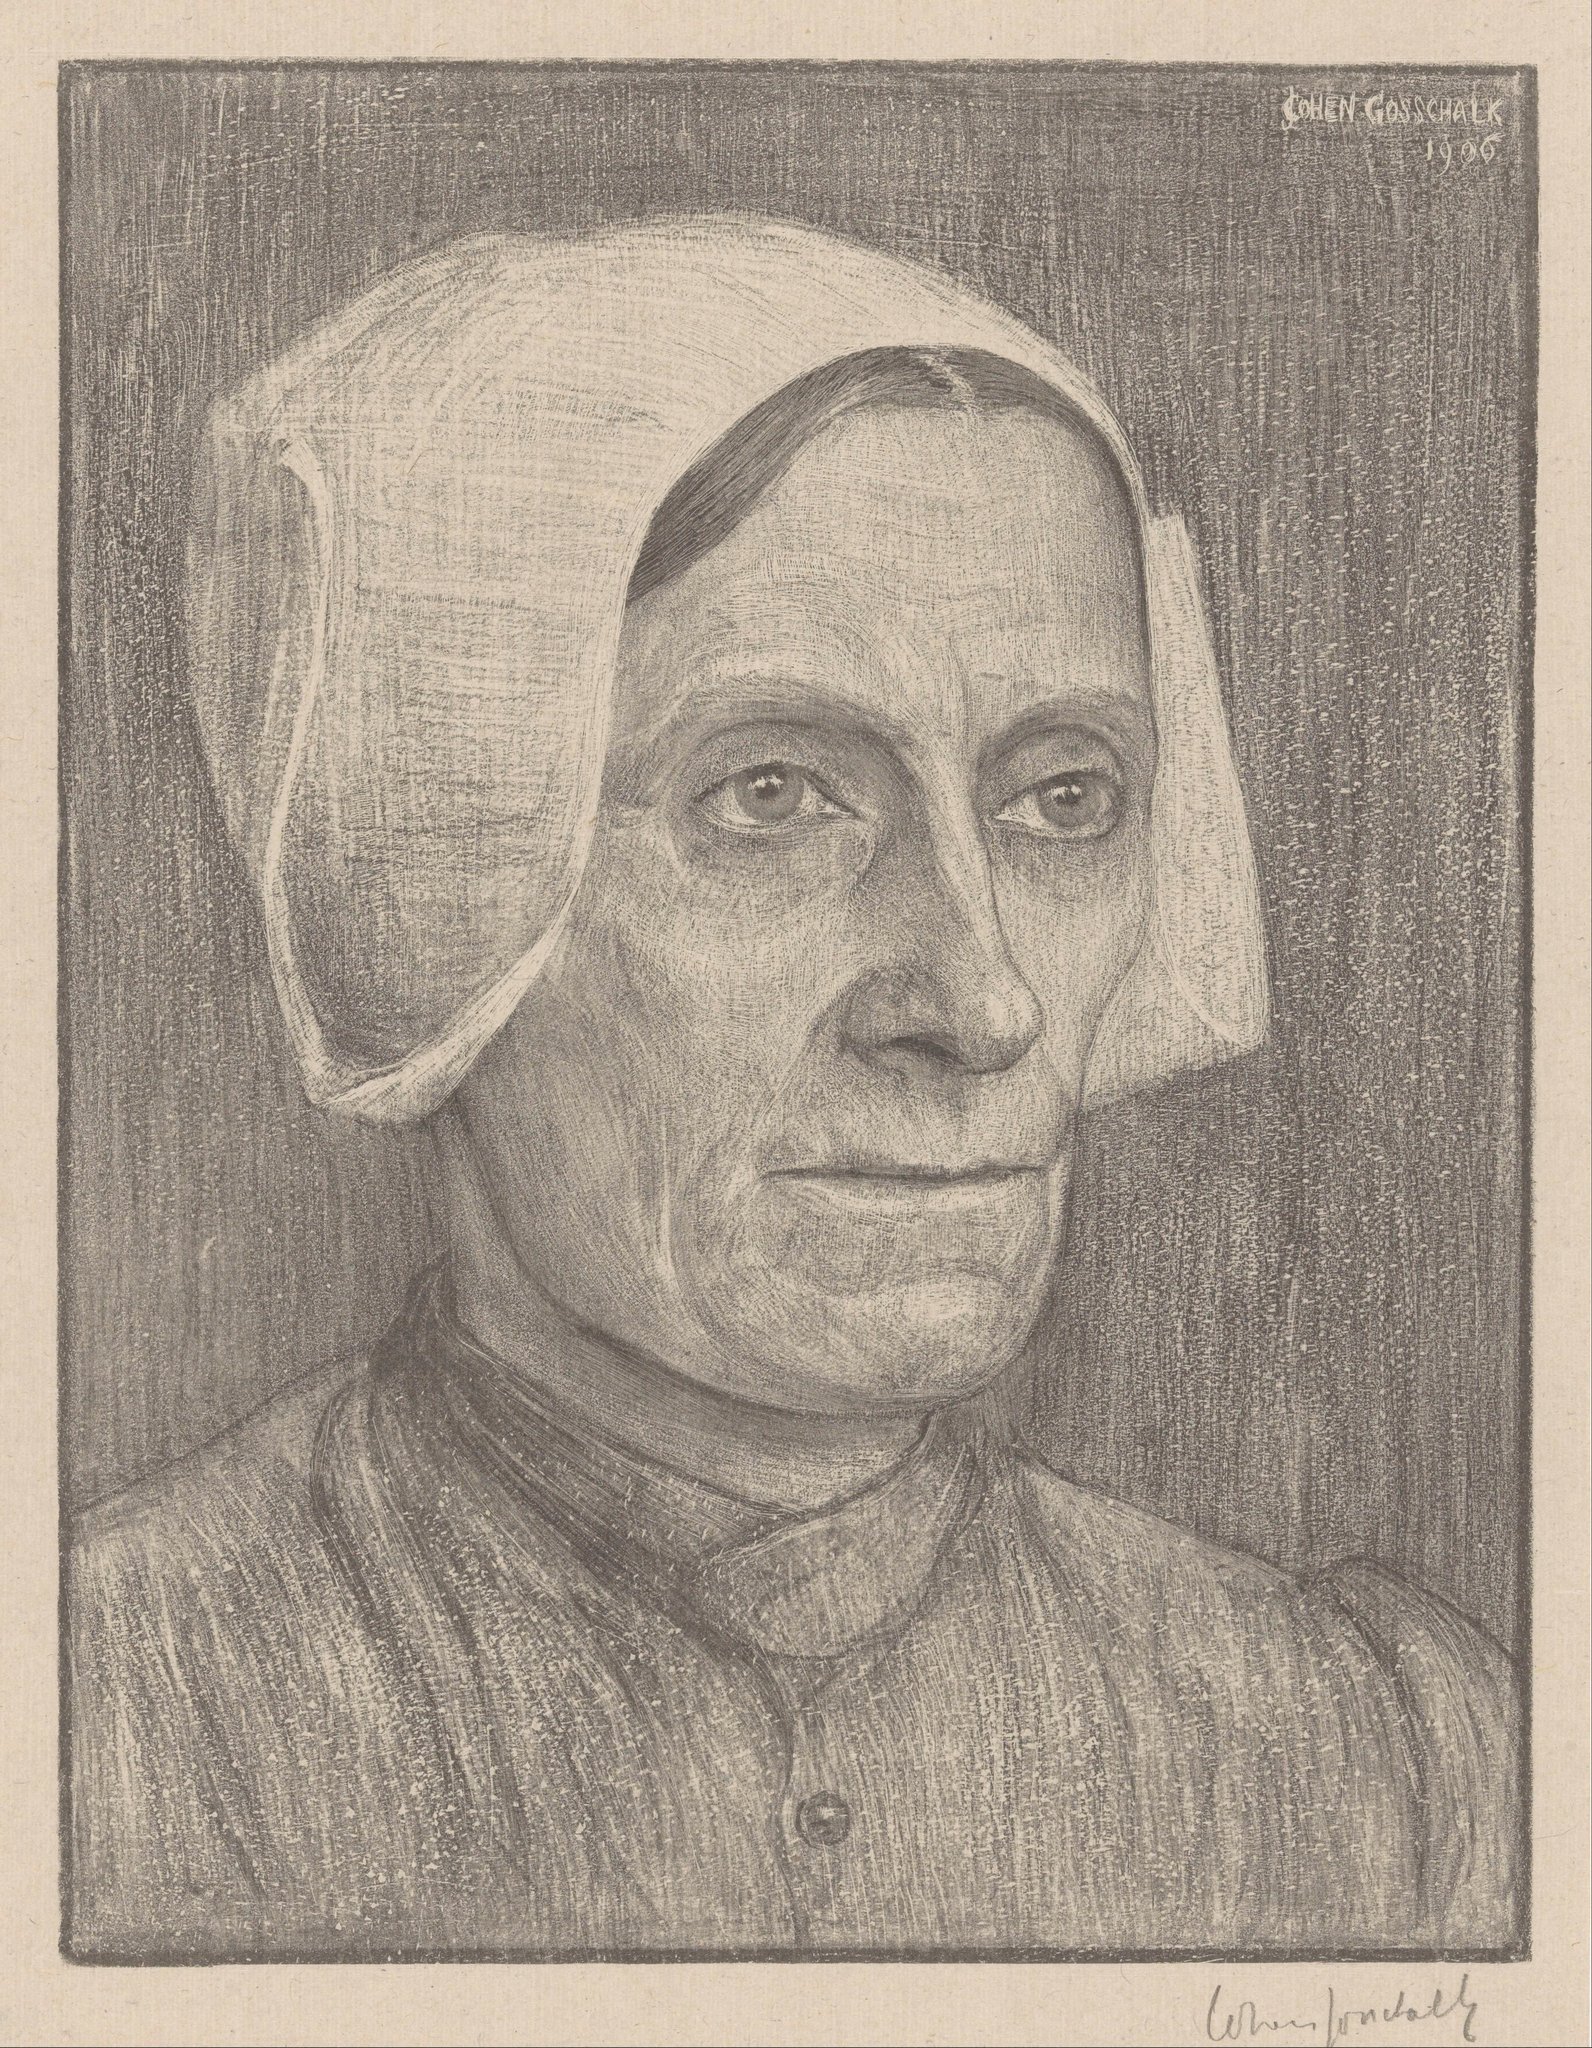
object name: print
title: Portret van een onbekende vrouw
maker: johan henri gustaaf cohen gosschalk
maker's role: draughtsman, print maker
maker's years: 1873-1912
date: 1906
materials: paper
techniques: lithograph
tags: anonymous historical person portrayed alone - bb - woman, folk costume, regional costume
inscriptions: collector's mark: Lugt 2228